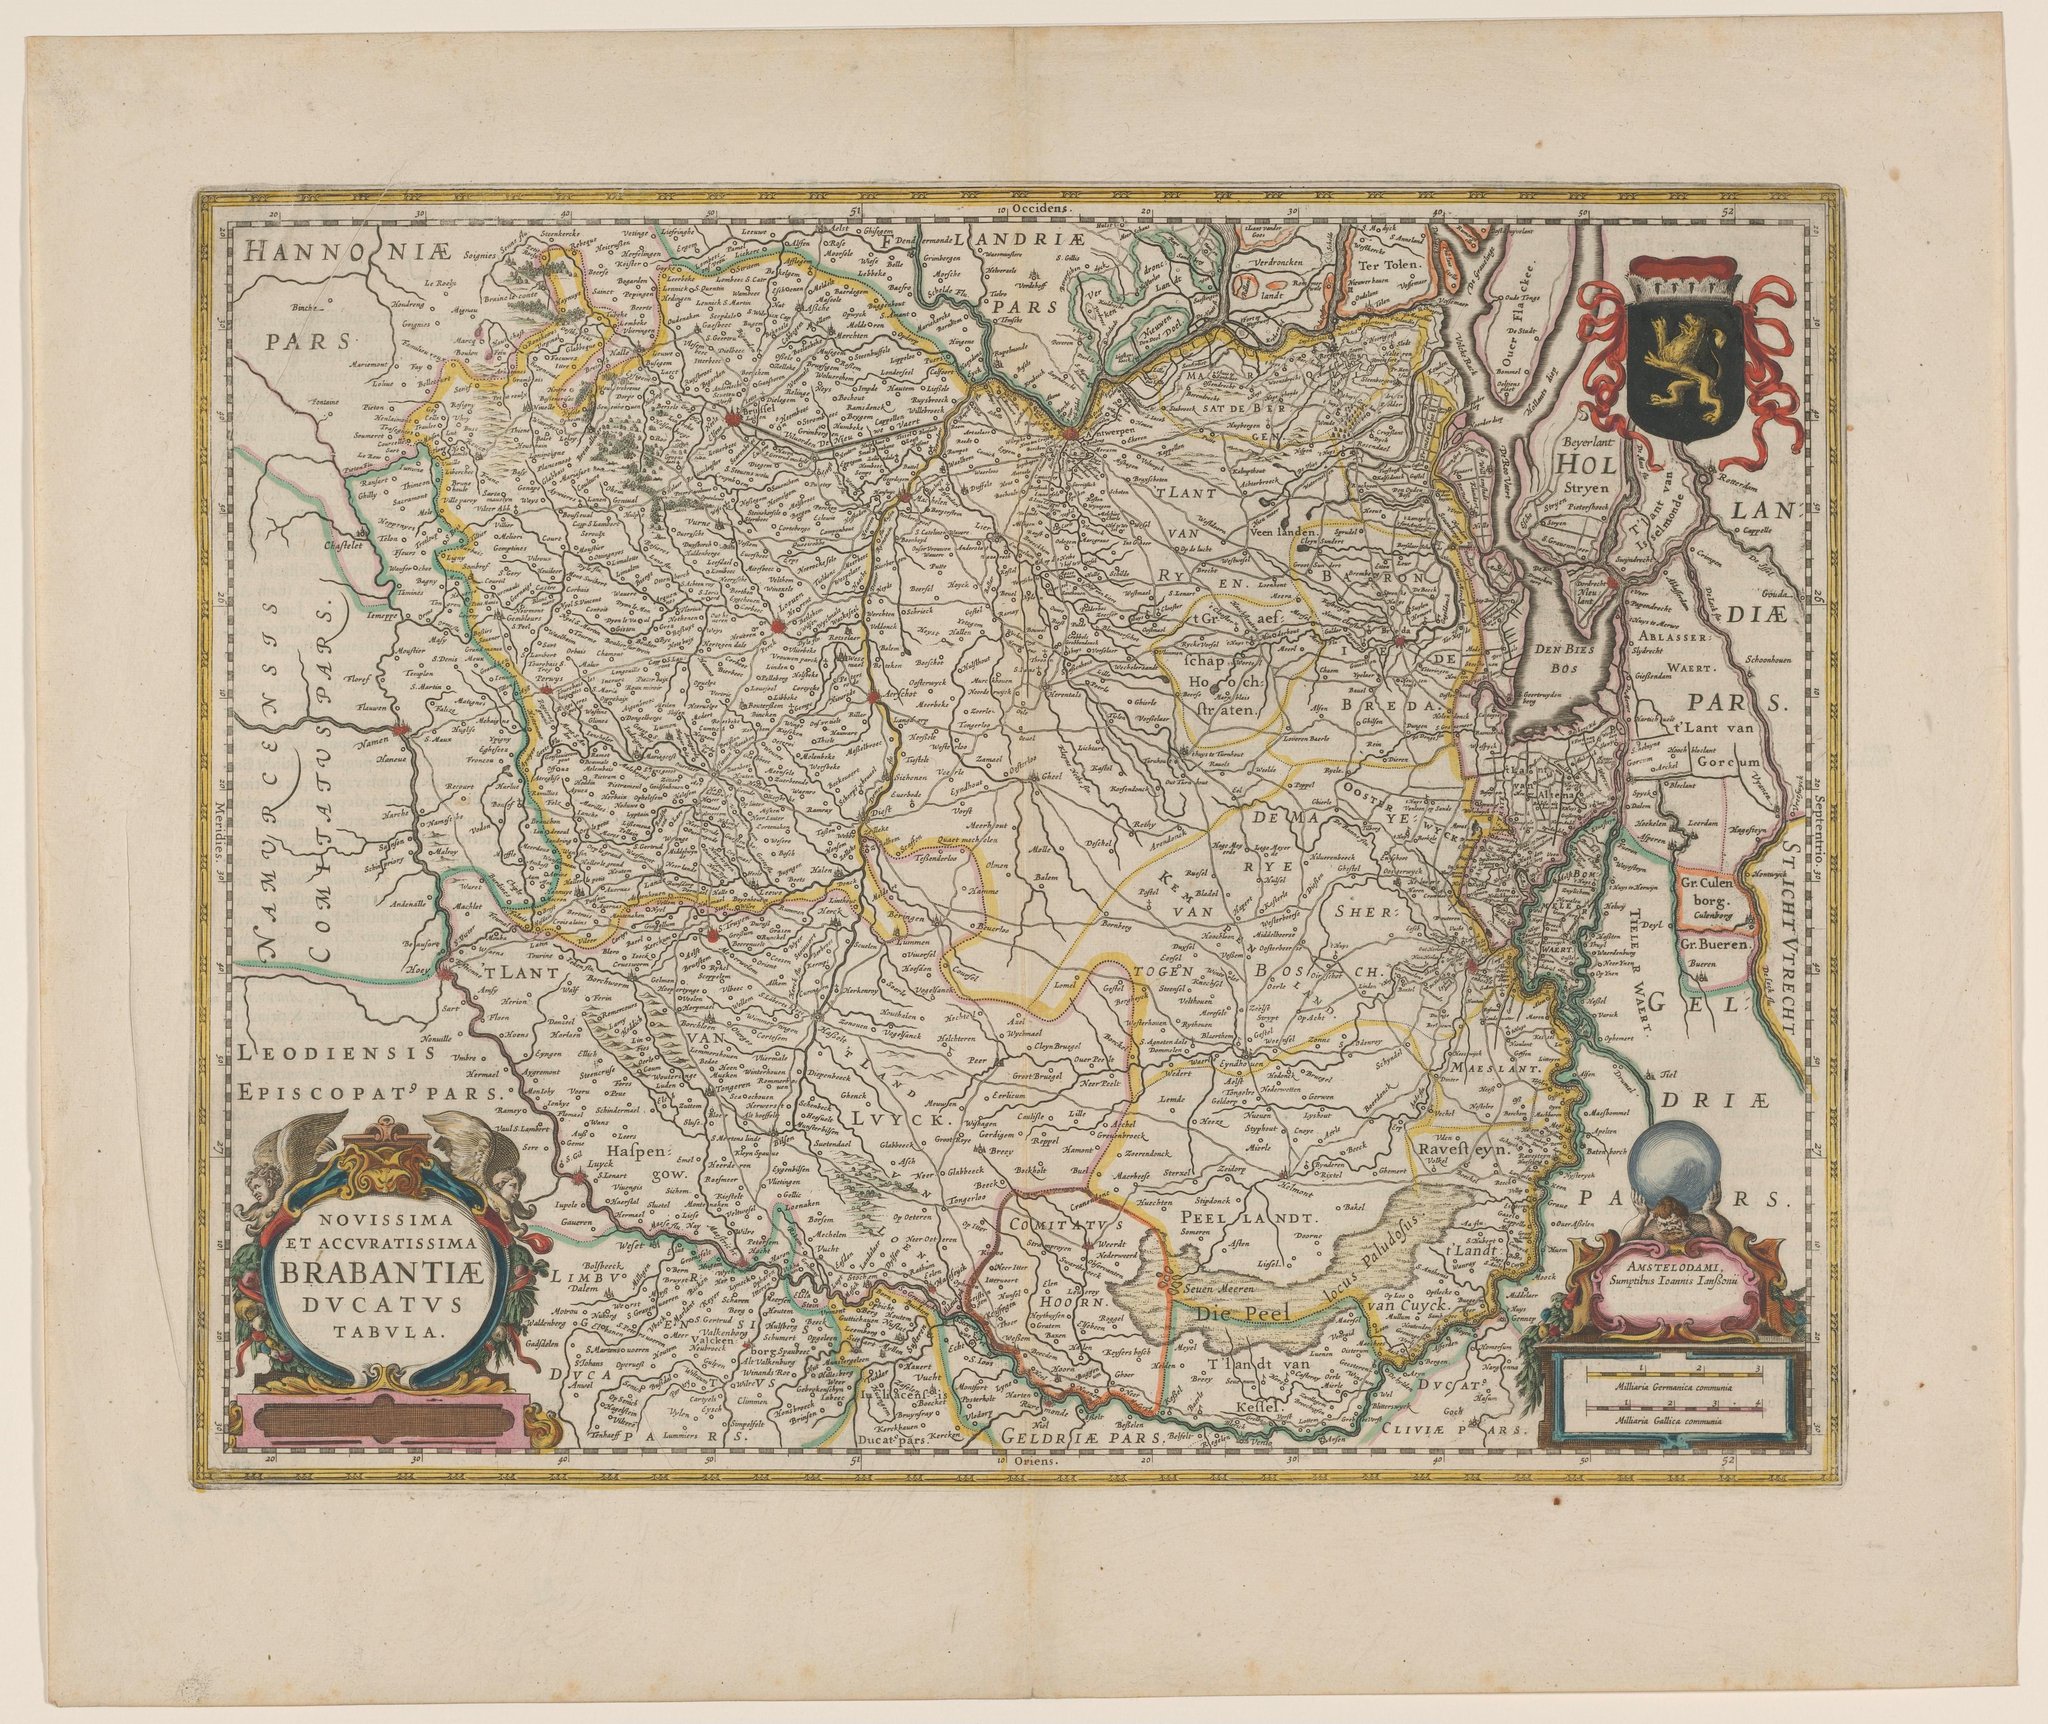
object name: print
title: Kaart van het hertogdom Brabant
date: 1666-1680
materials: paper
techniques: engraving, etching, hand coloring, letterpress printing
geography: amsterdam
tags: maps of separate countries or regions, coat of arms (as symbol of the state, etc.) (+ province; provincial), brabant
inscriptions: collector's mark: Lugt 2228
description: Prent gebruikt in: Janssonius, Johannes. Atlas Contractus, sive Atlantis Majoris Compendium (…). 2 delen. Amsterdam: erven Johannes Janssonius, 1666, dl. 1. Of in: Janssonius, Johannes. Atlas Major, sive Cosmographia Universalis (…). Amsterdam: erven Johannes Janssonius, 1675, dl. 3. Of in: Novus Atlas, sive Theatrum Orbis Terrarum: Tabulae & Descriptiones Omnium Regionum Totius Universi Accuratissime Exhibentur. 5 delen. Amsterdam: Johannes Janssonius van Waesberge (I), s.d. [na ca. 1680], dl. 2.